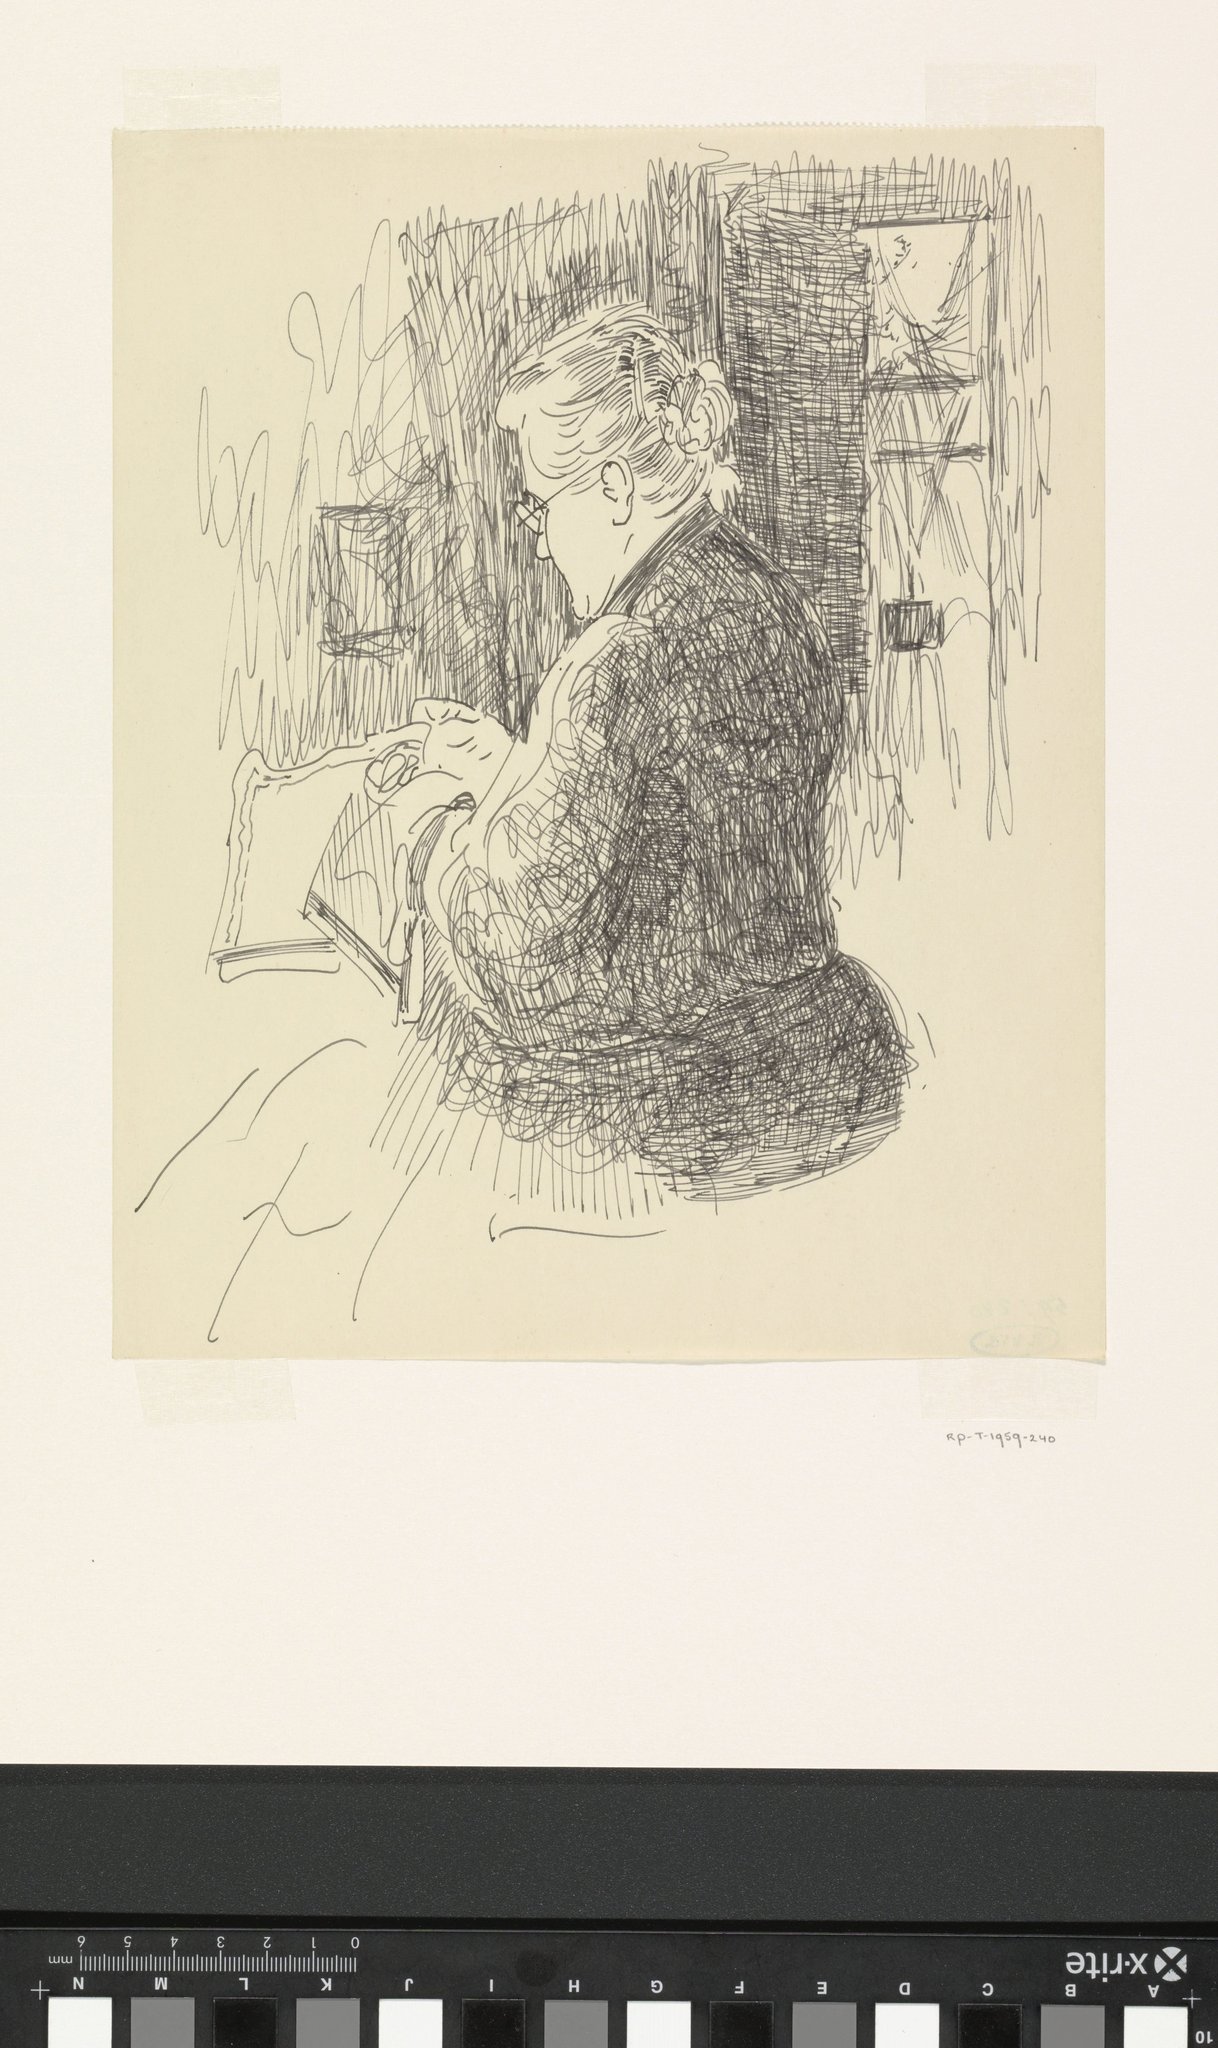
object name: drawing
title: Studie van de echtgenote van Carel Adolph Lion Cachet, handwerkend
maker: carel adolph lion cachet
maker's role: draughtsman, print maker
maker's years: 1864-1945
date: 1874-1945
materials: ink, paper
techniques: pen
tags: historical persons - bb - woman, (other forms of) needlework, e.g.: crocheting, knitting, embroidering